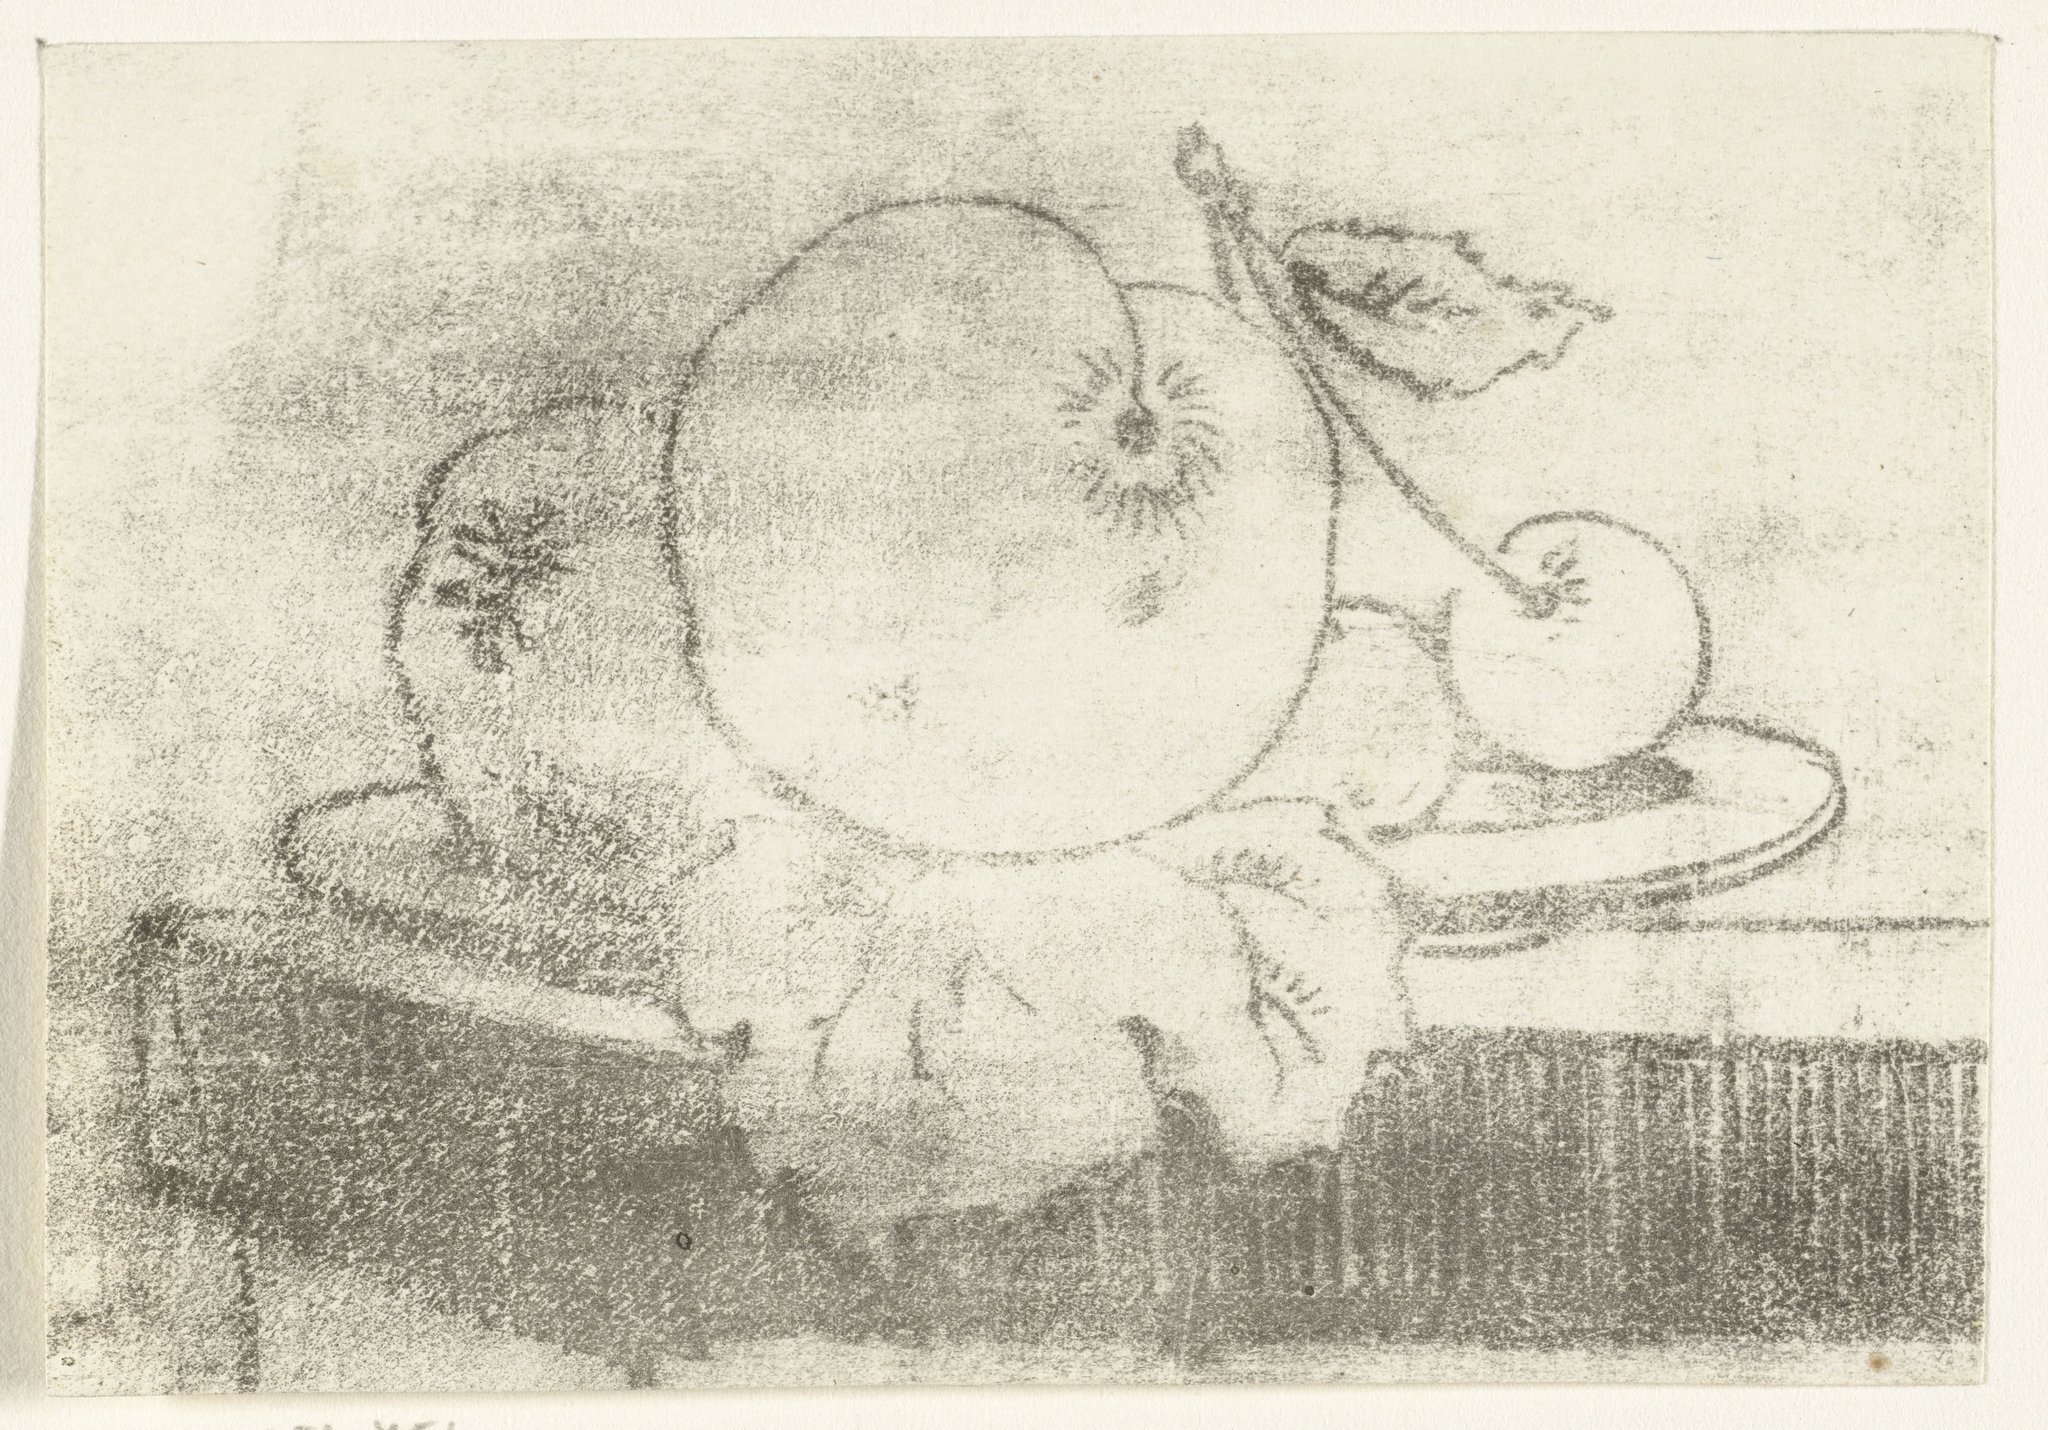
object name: print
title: Vruchten op een schaal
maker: pieter barbiers (iv)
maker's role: painter, print maker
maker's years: 1798-1848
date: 1808-1848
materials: paper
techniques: soft ground etching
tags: fruits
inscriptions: collector's mark: Lugt 2228